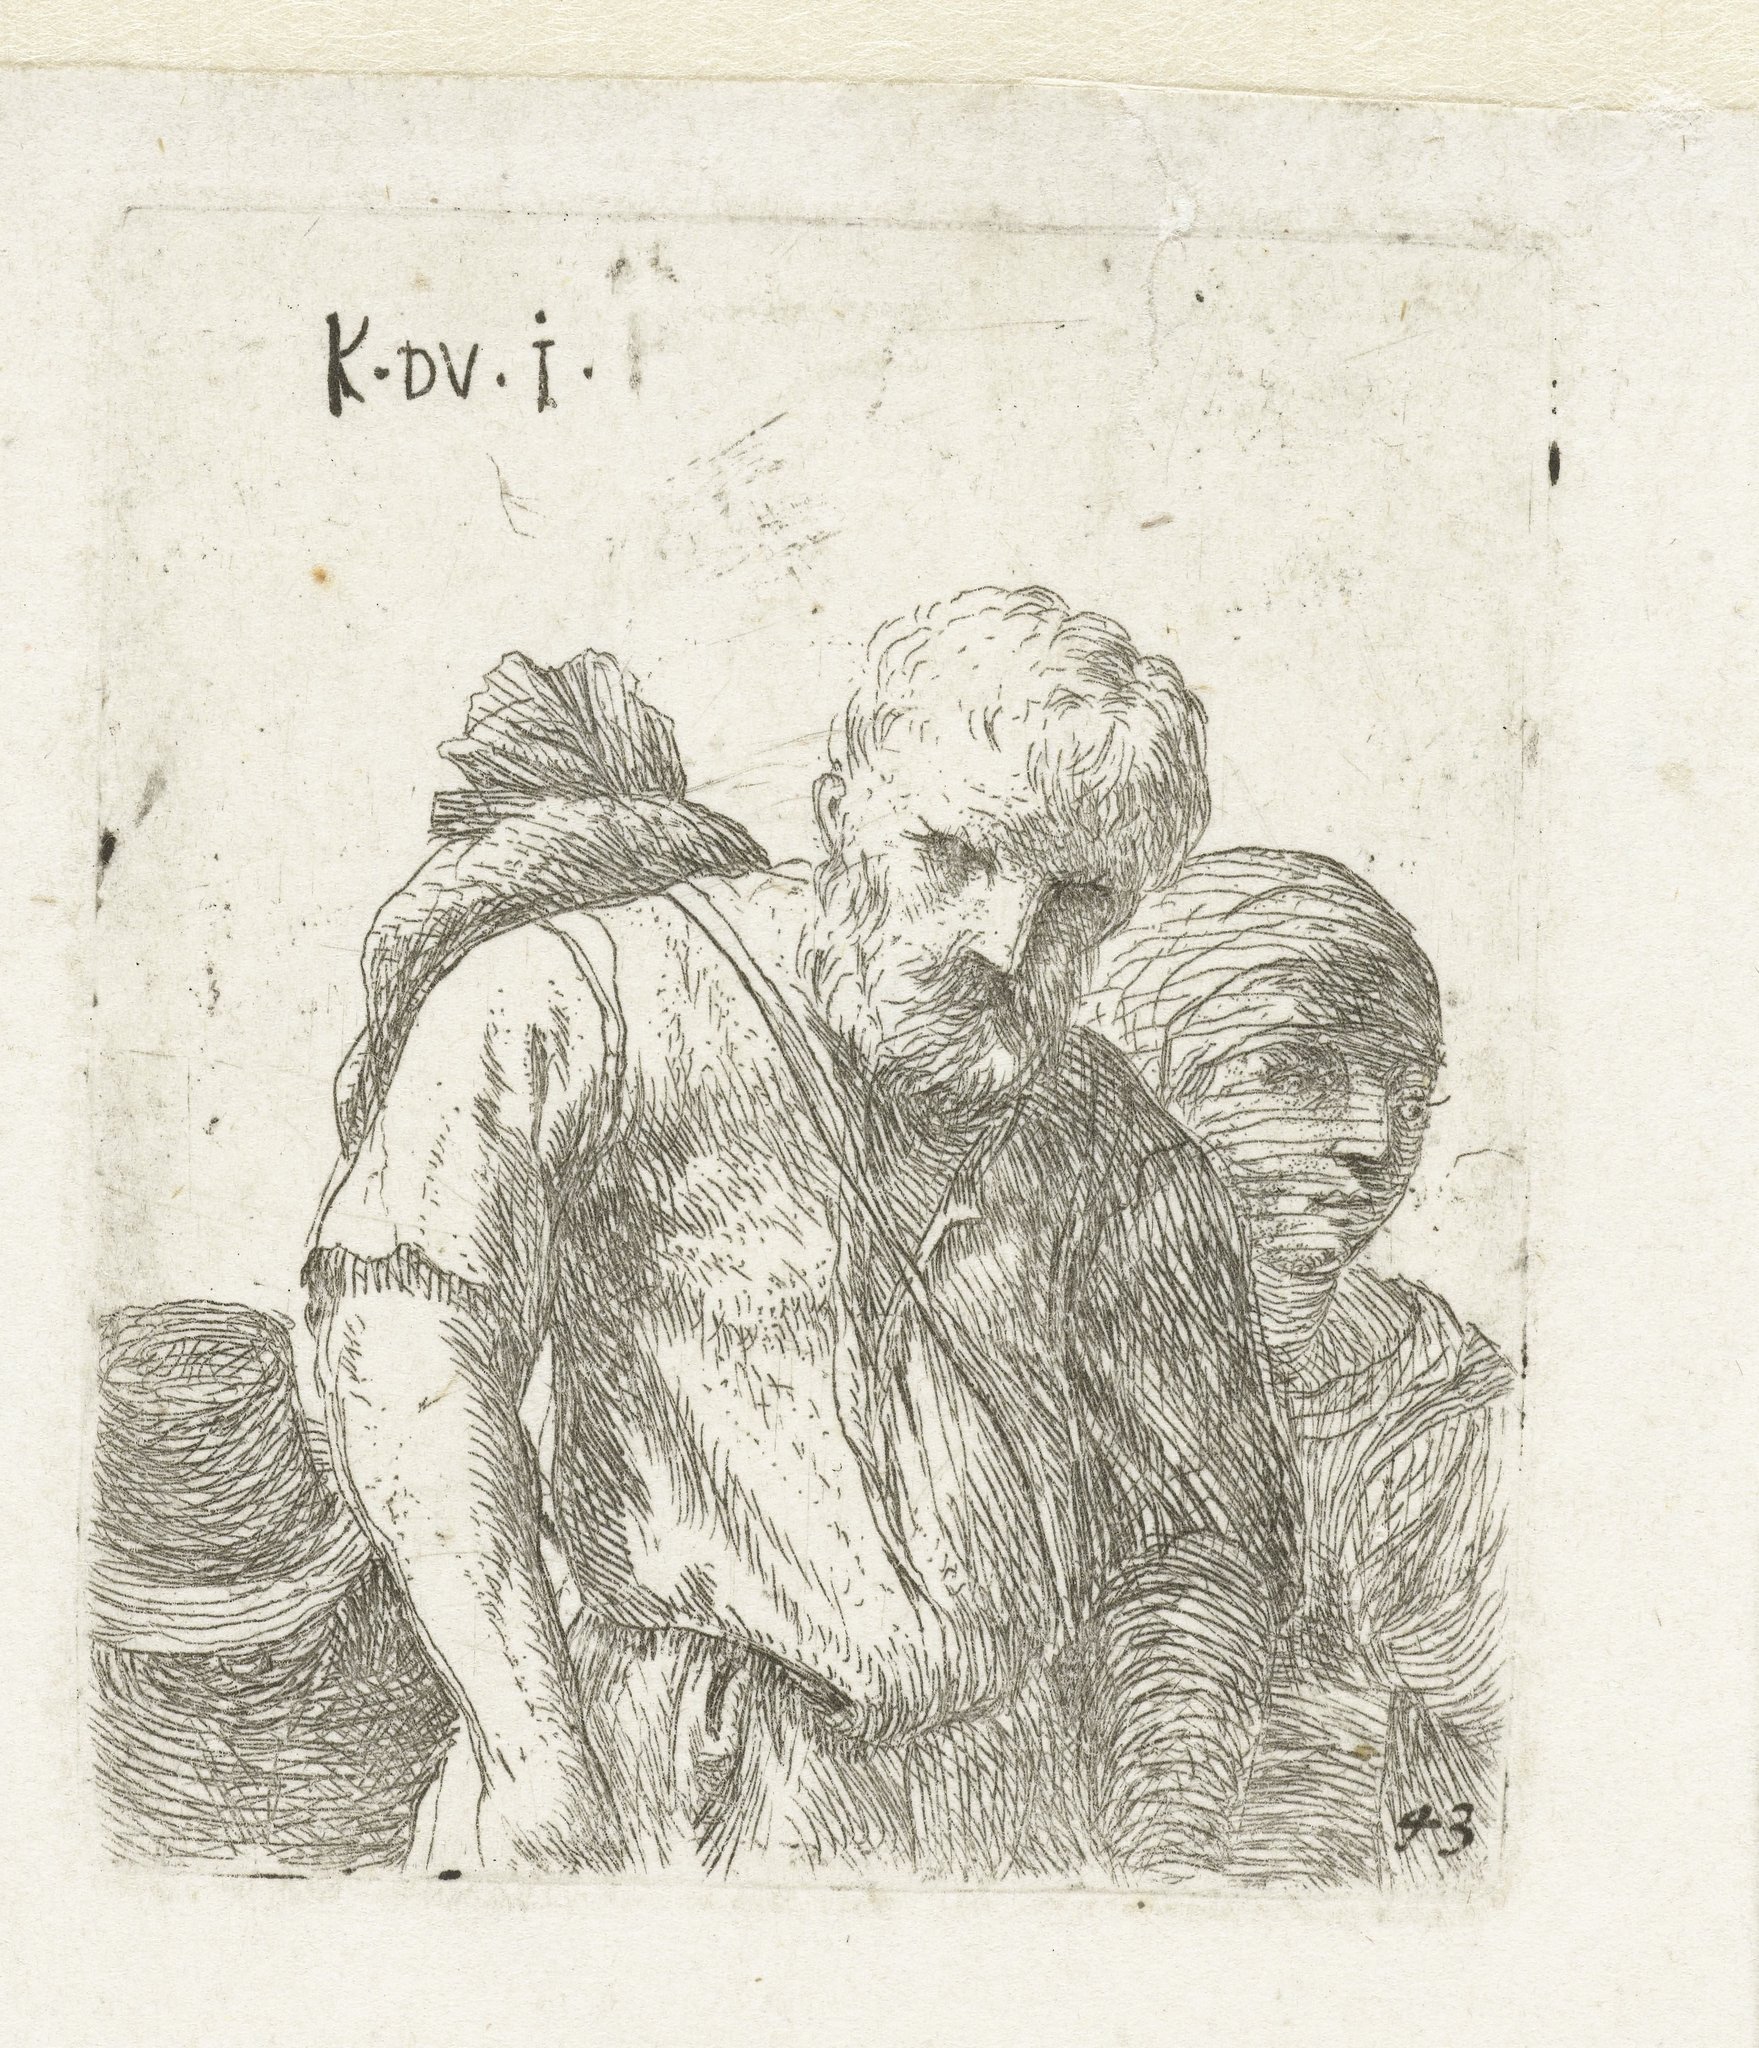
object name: print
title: De familie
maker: karel du jardin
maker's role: draughtsman, painter, print maker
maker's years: 1626-1678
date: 1652-1659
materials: paper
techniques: etching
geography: netherlands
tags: male sex; man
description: Maakt deel uit van blad met acht kleine etsen